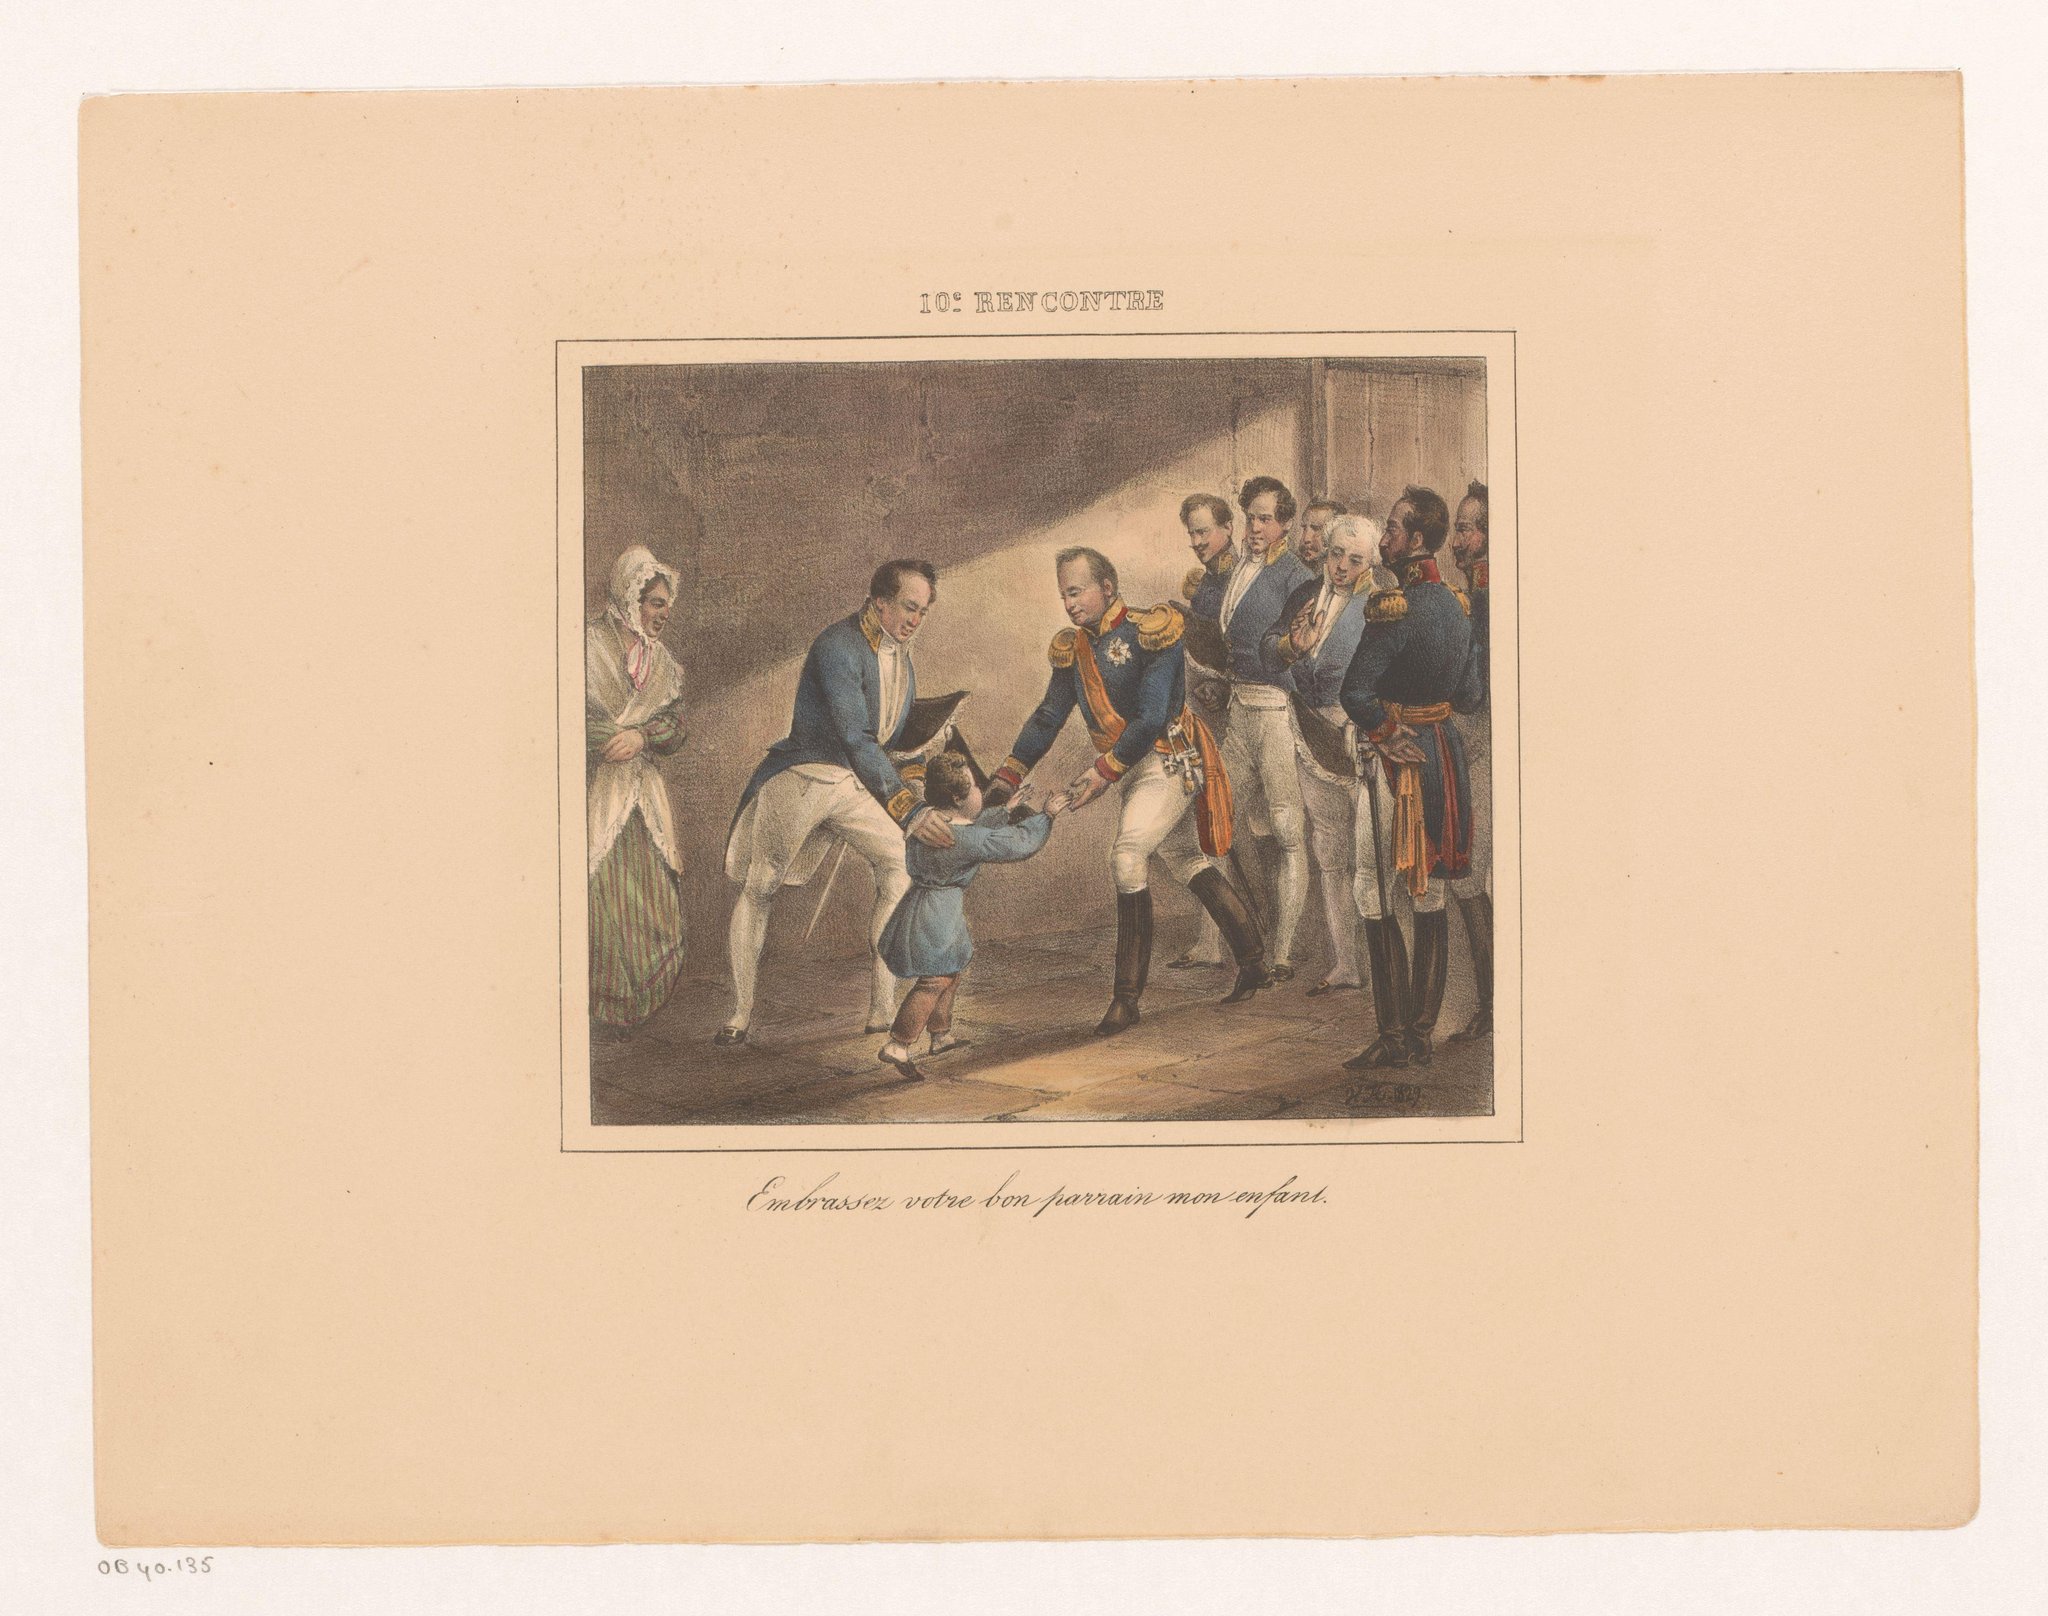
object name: print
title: 10e Rencontre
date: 1829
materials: paper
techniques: hand coloring, lithograph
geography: brussels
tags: william i of the netherlands, ruler in informal contact with his subjects, godfather and godmother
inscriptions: collector's mark: Lugt 2228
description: De koning ontmoet een kind waarover hij peet is. Met eenregelig onderschrift. Onderdeel van de serie van 24 platen met ontmoetingen met koning Willem I, verschenen onder de titel 'Les rencontres' in 1829-1830.